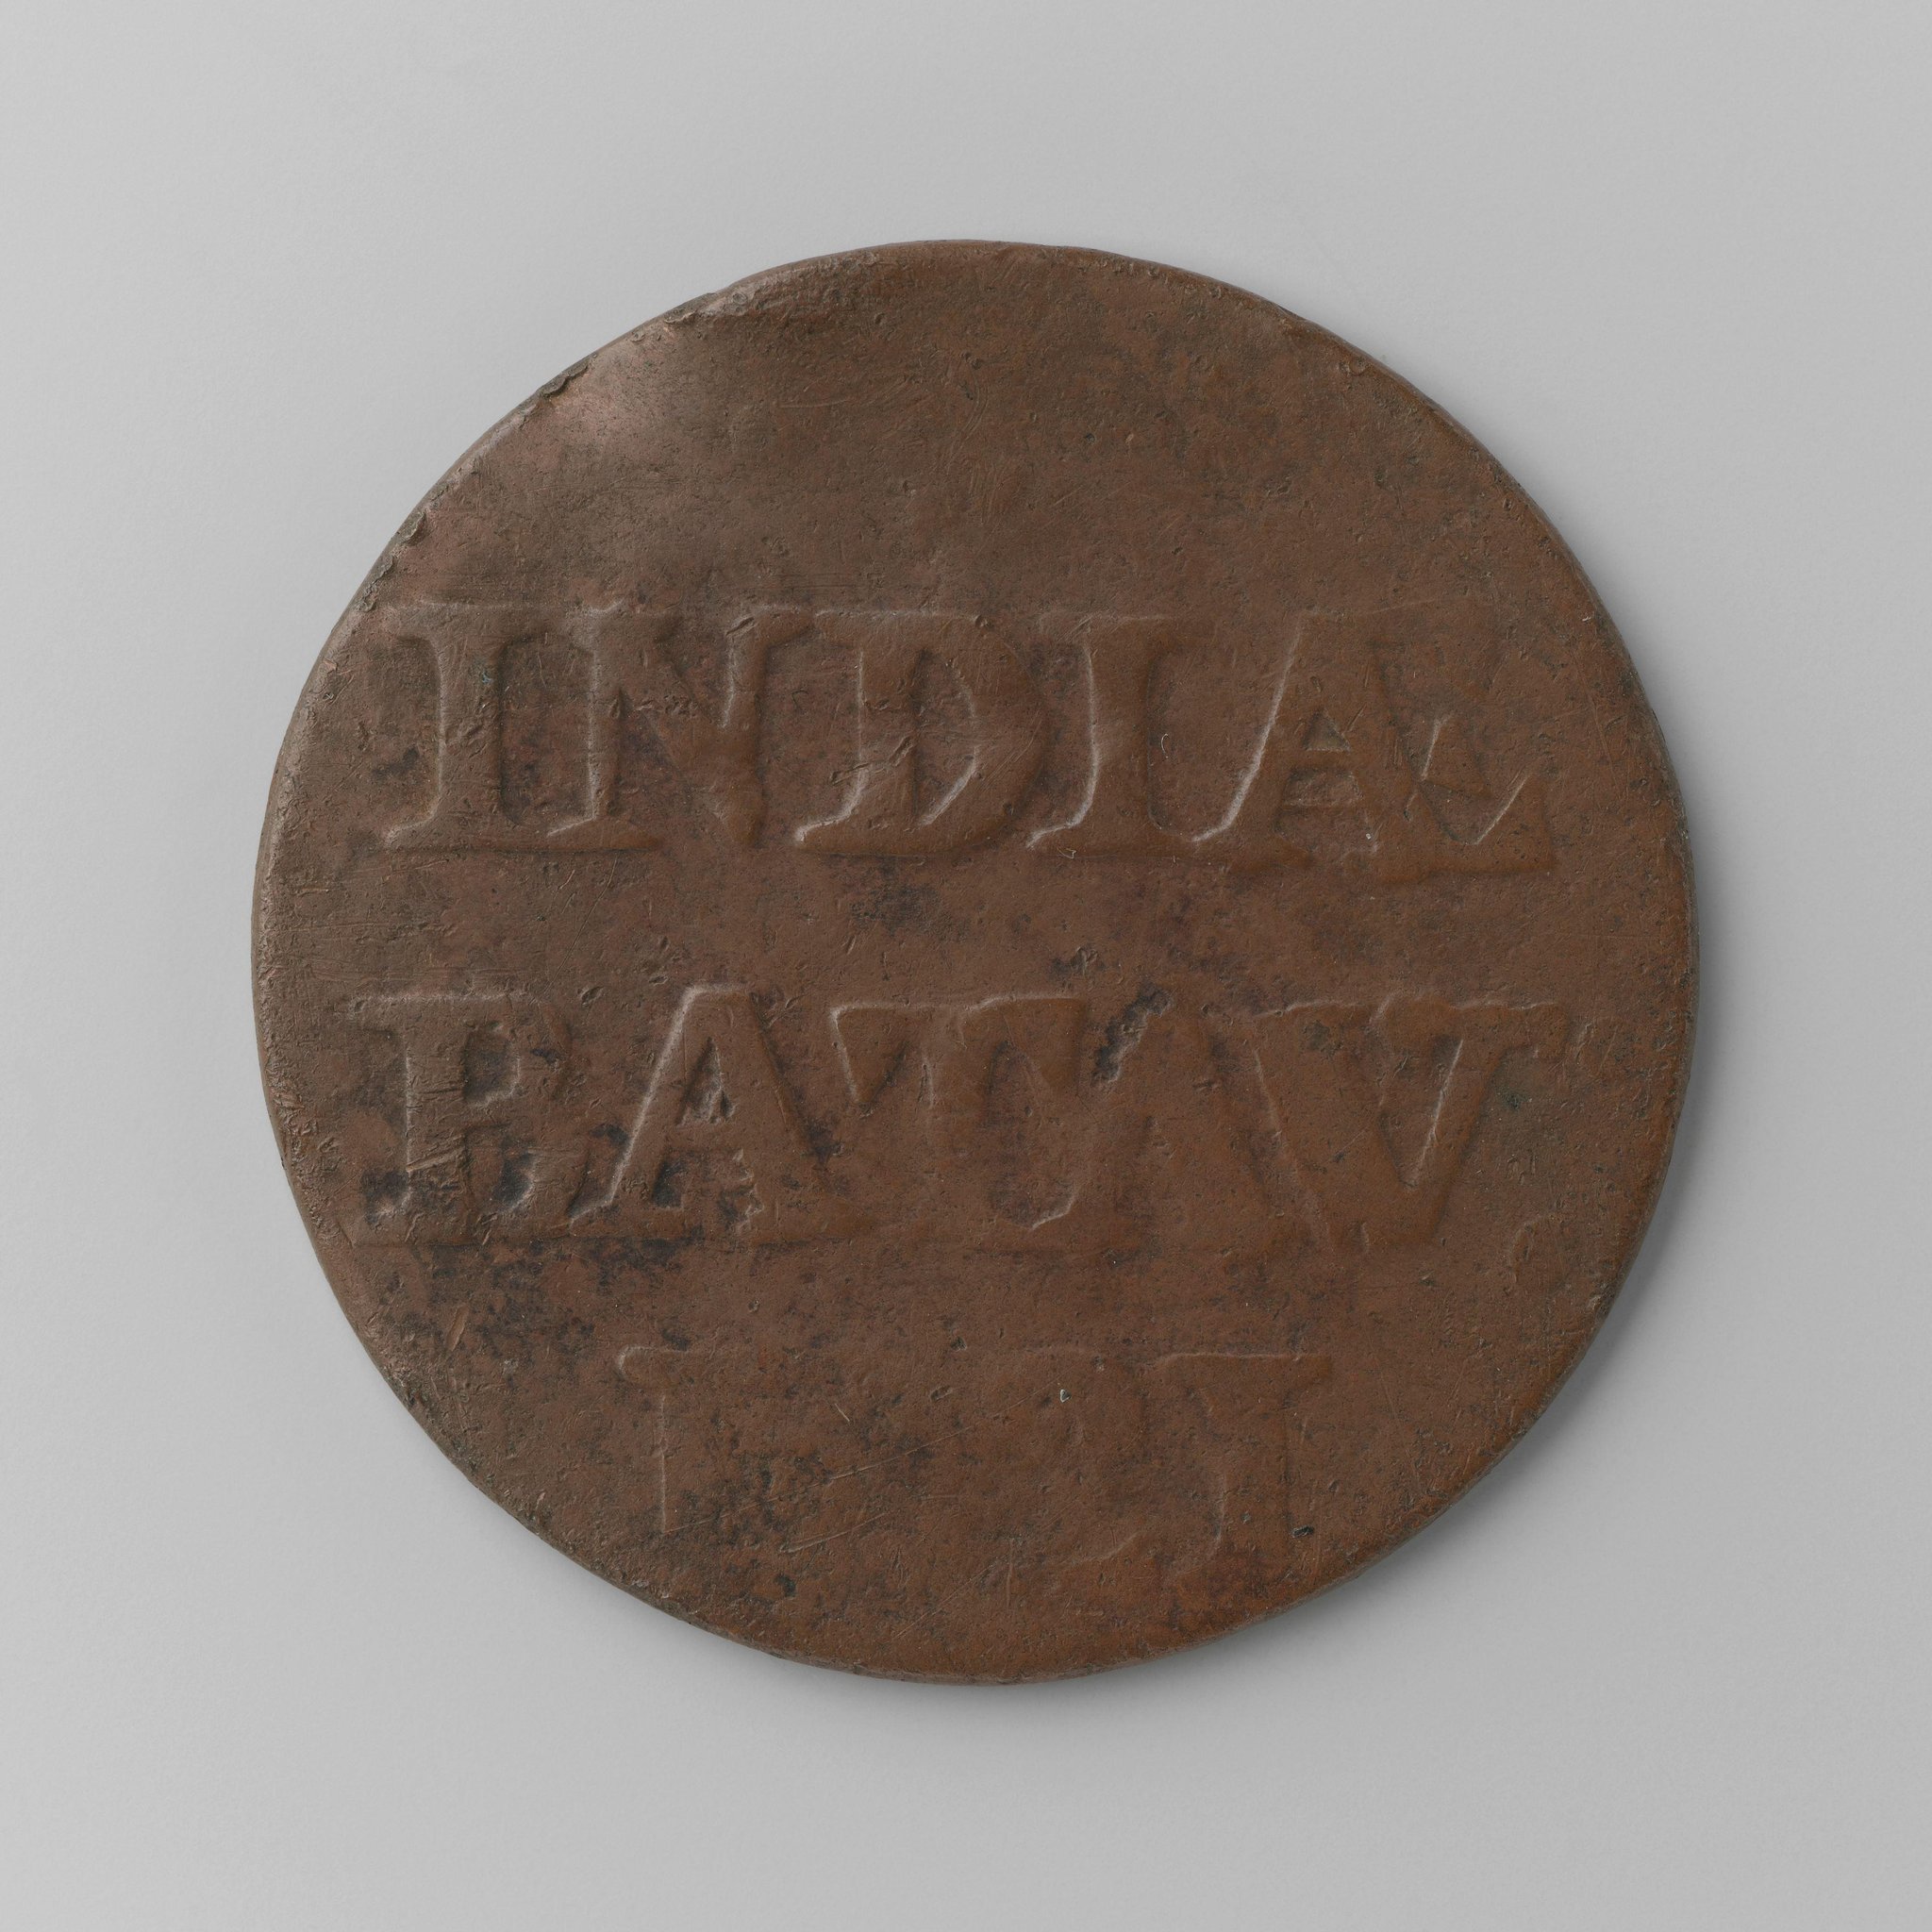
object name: coin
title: ½ stuiver van Nederlands Indië, 1821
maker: william i of the netherlands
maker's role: koning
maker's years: 1772-1843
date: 1821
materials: copper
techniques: striking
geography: surabaya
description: Koperen munt. Voorzijde: tussen waarde-aanduiding ½ St. gekroond generaliteitswapenschild. Keerzijde: tweeregelig opschrift, waarboven muntteken en waaronder jaartal. Gladde rand.